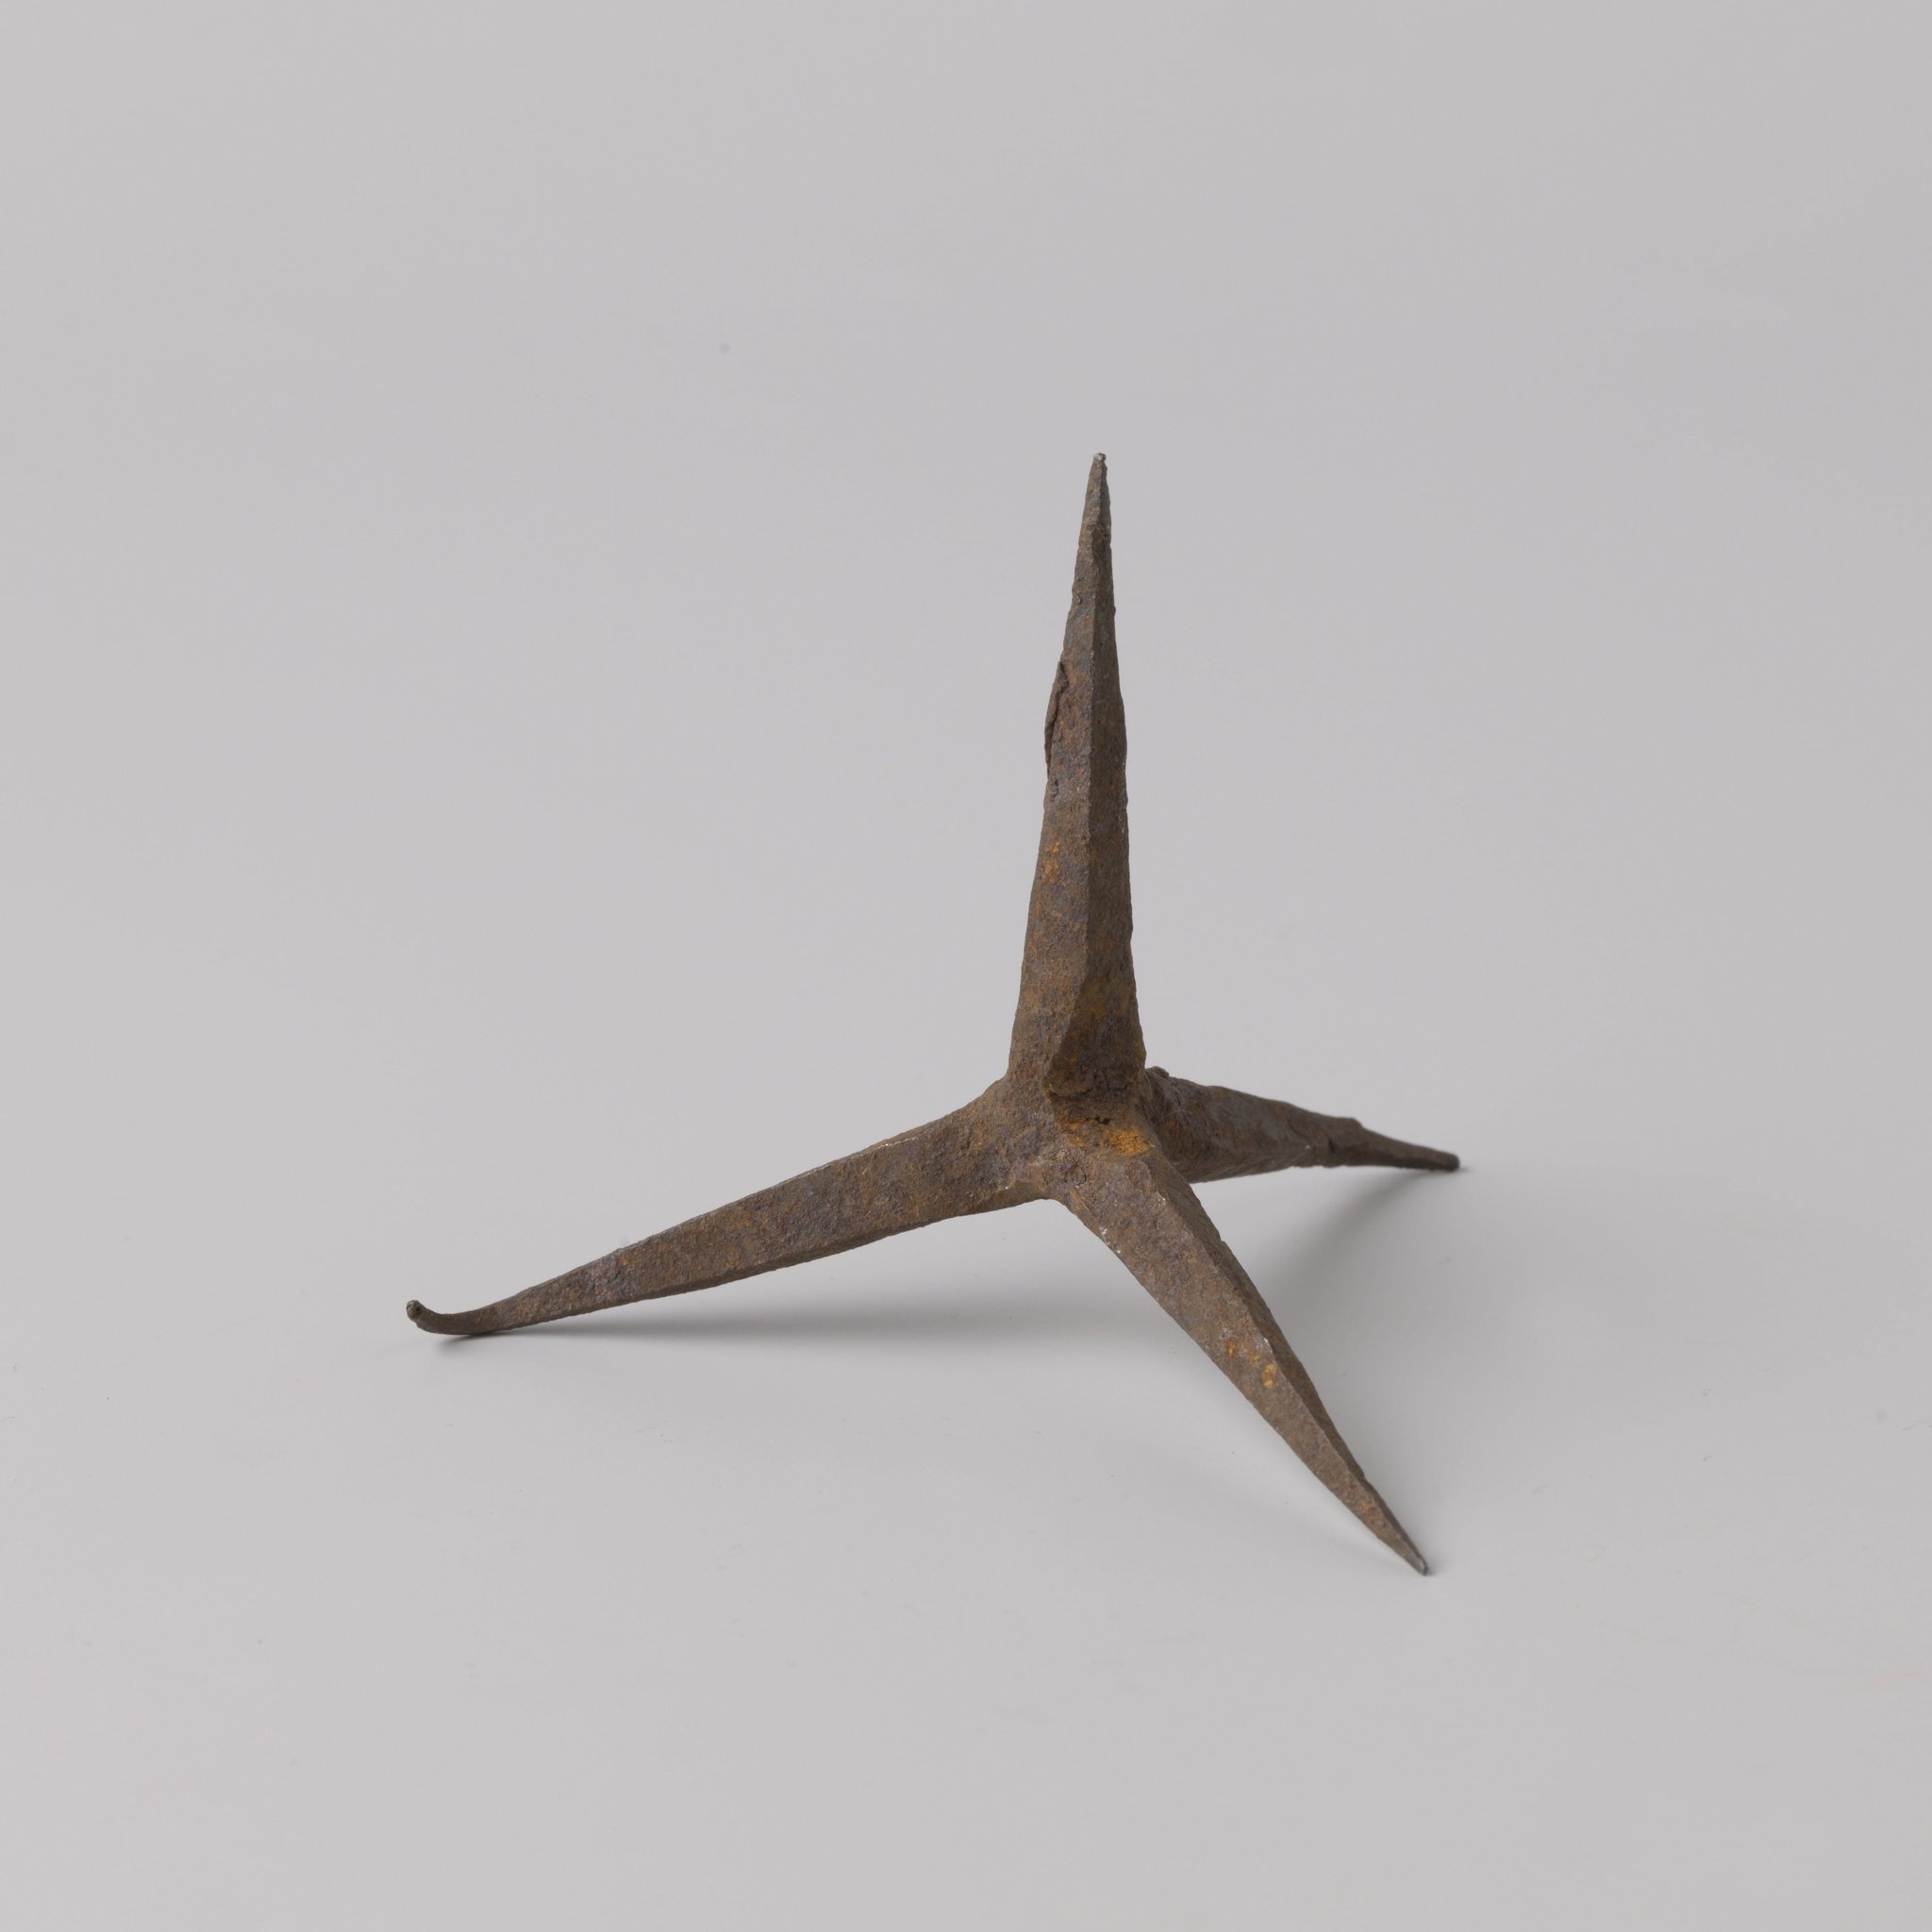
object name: caltrop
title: Voetangel of kraaienpoot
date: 1600-1699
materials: iron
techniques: forging, striking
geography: scandinavia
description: IJzeren voetangel of kraaiepoot met vier punten.